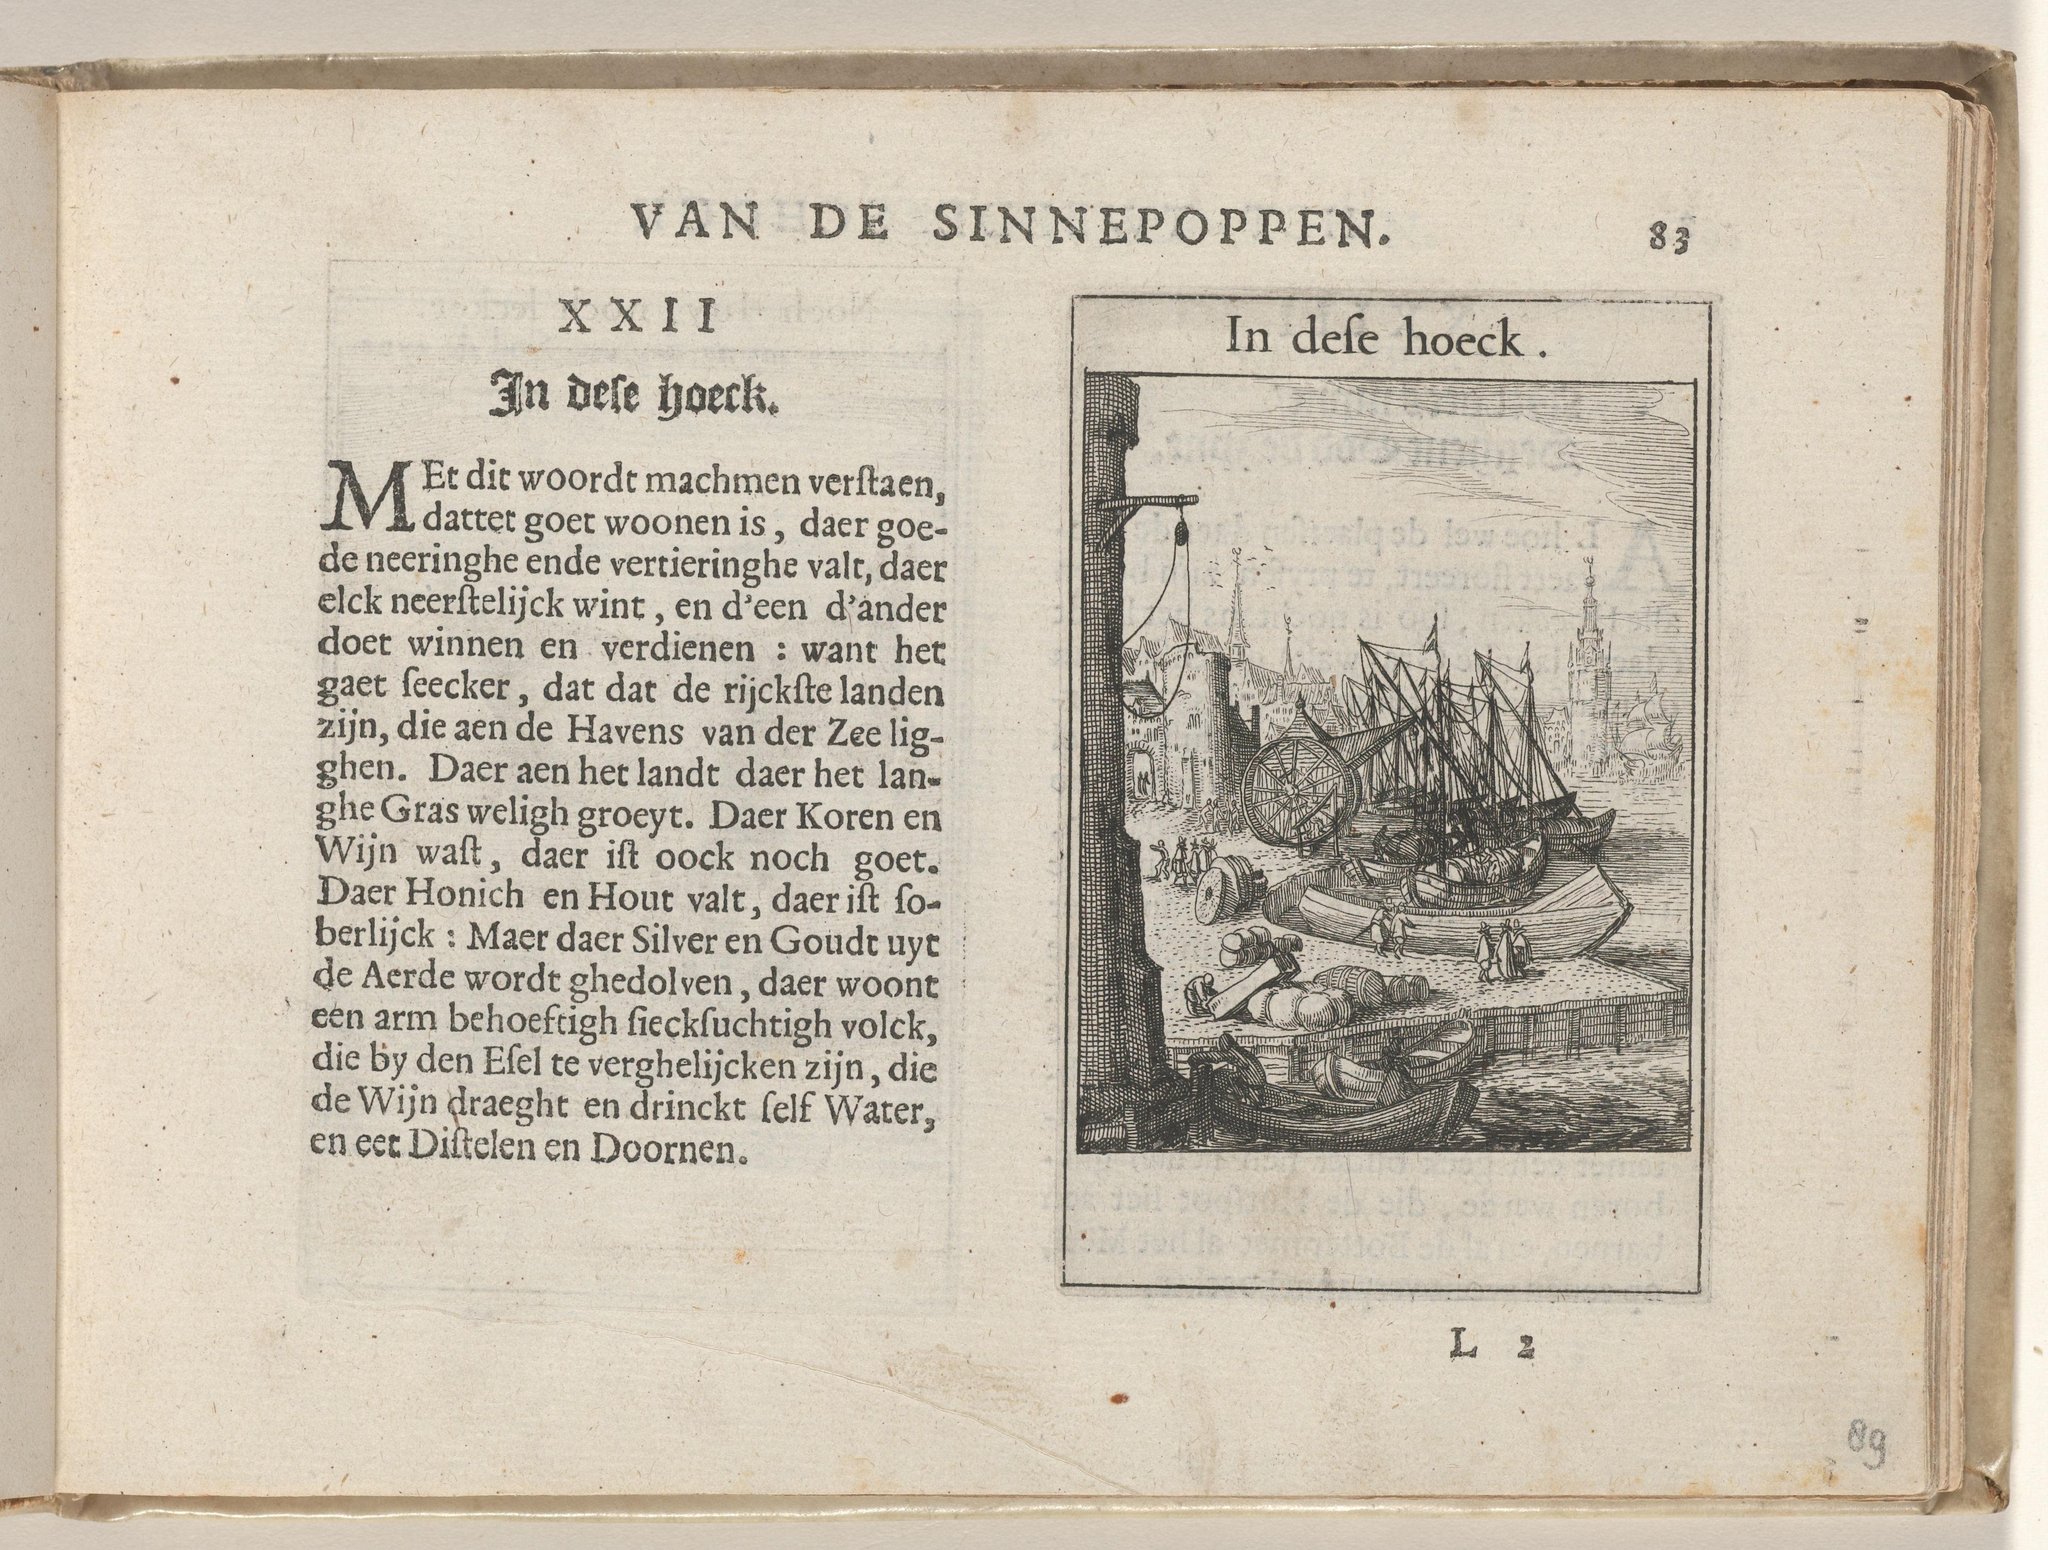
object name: print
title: XXII In dese hoeck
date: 1614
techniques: engraving, printing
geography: amsterdam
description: XXII In dese hoeck. Tweede schok. Onderdeel van 'Sinnepoppen', R. Visscher, 1614.